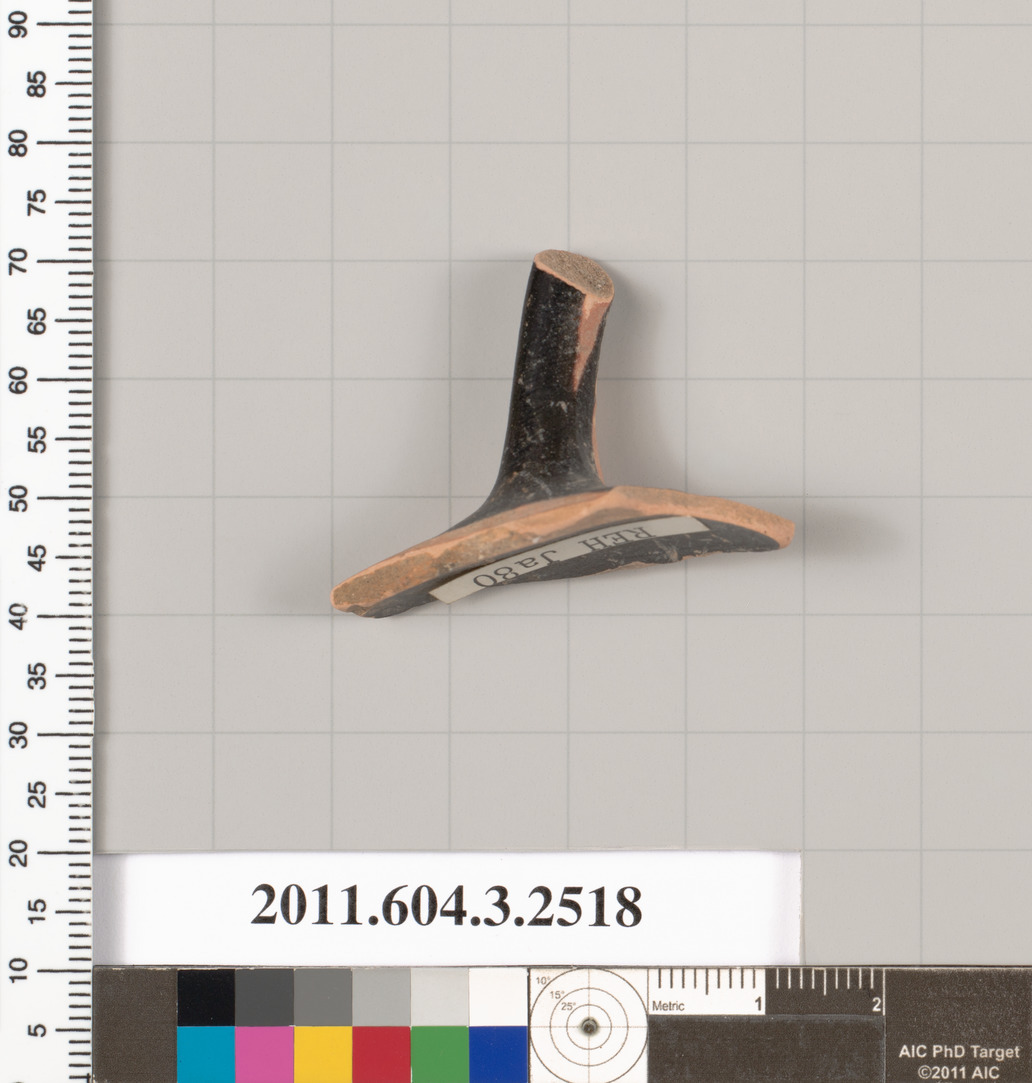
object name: kylix fragment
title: Terracotta fragment of a skyphos (deep drinking cup)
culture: greek, attic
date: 534-468 BCE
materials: terracotta